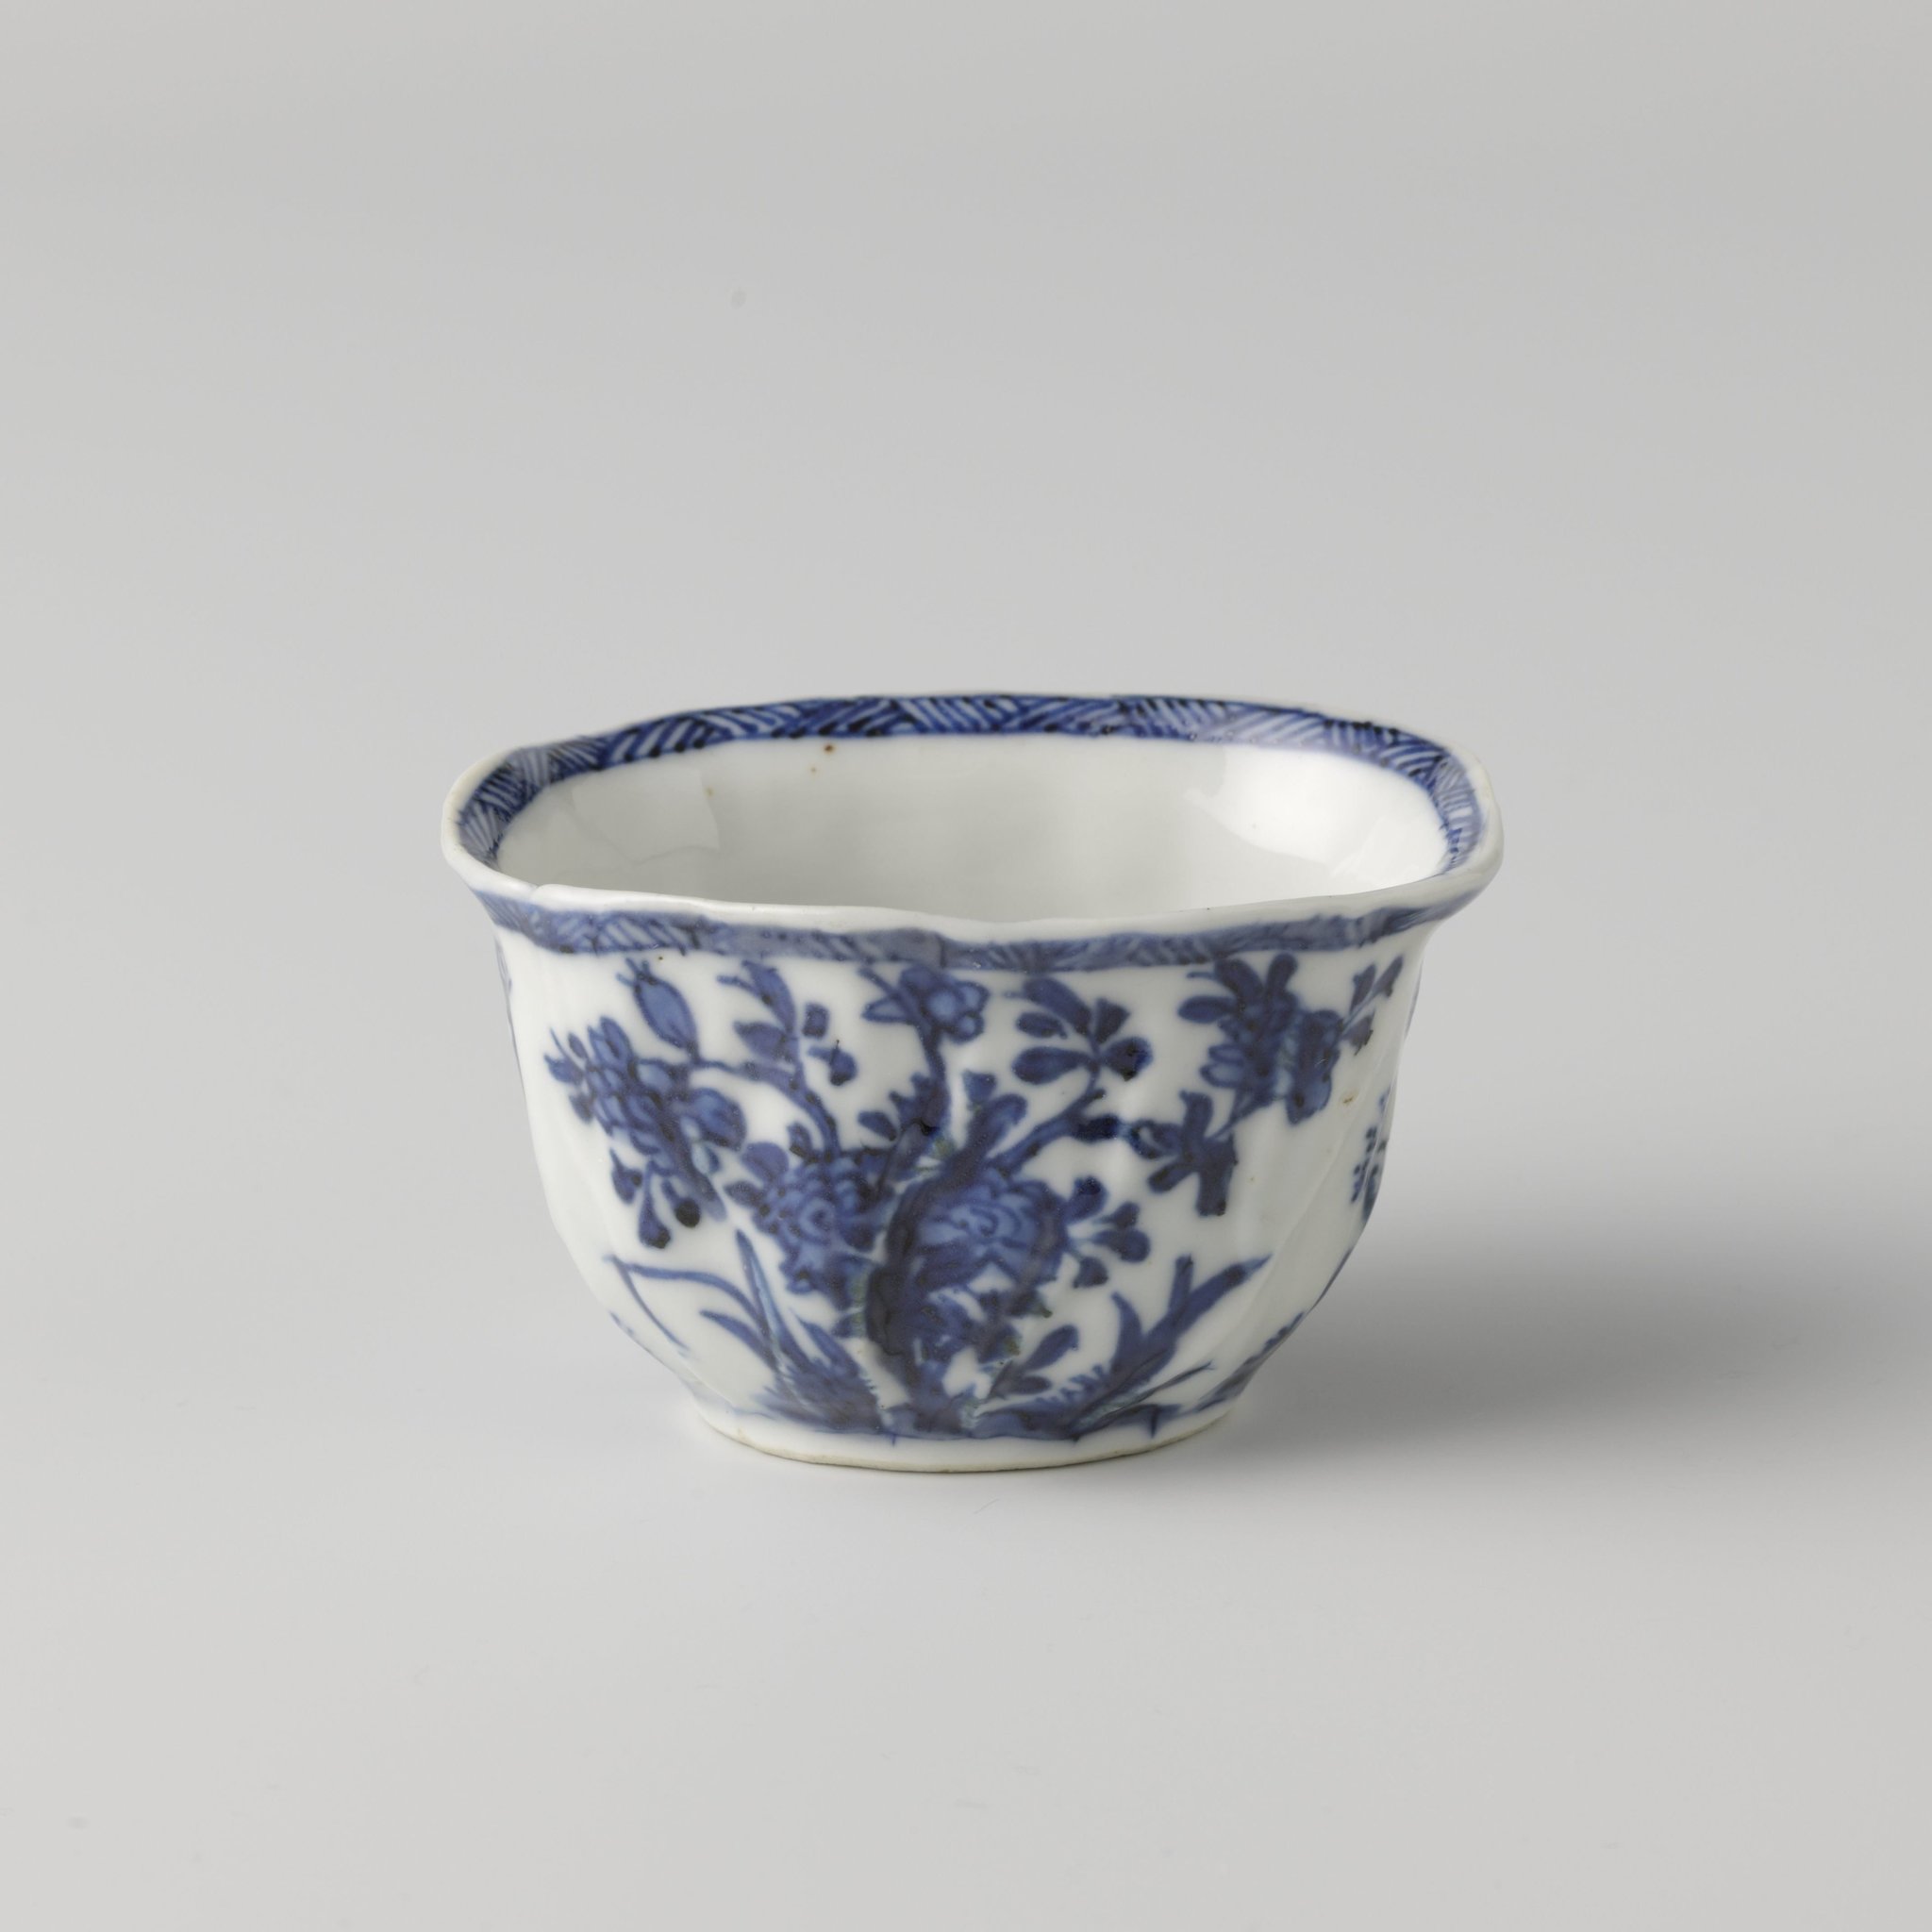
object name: cup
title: Cup in the shape of a leaf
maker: Anonymous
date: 1750-1774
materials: cobalt, glaze, paint, porcelain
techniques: firing, forming, turning, vitrification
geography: china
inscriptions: mark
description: Kop en schotel, schotel in de vorm van een blad met bloem- en bladversiering. (hoort bij AK-NM-13705)